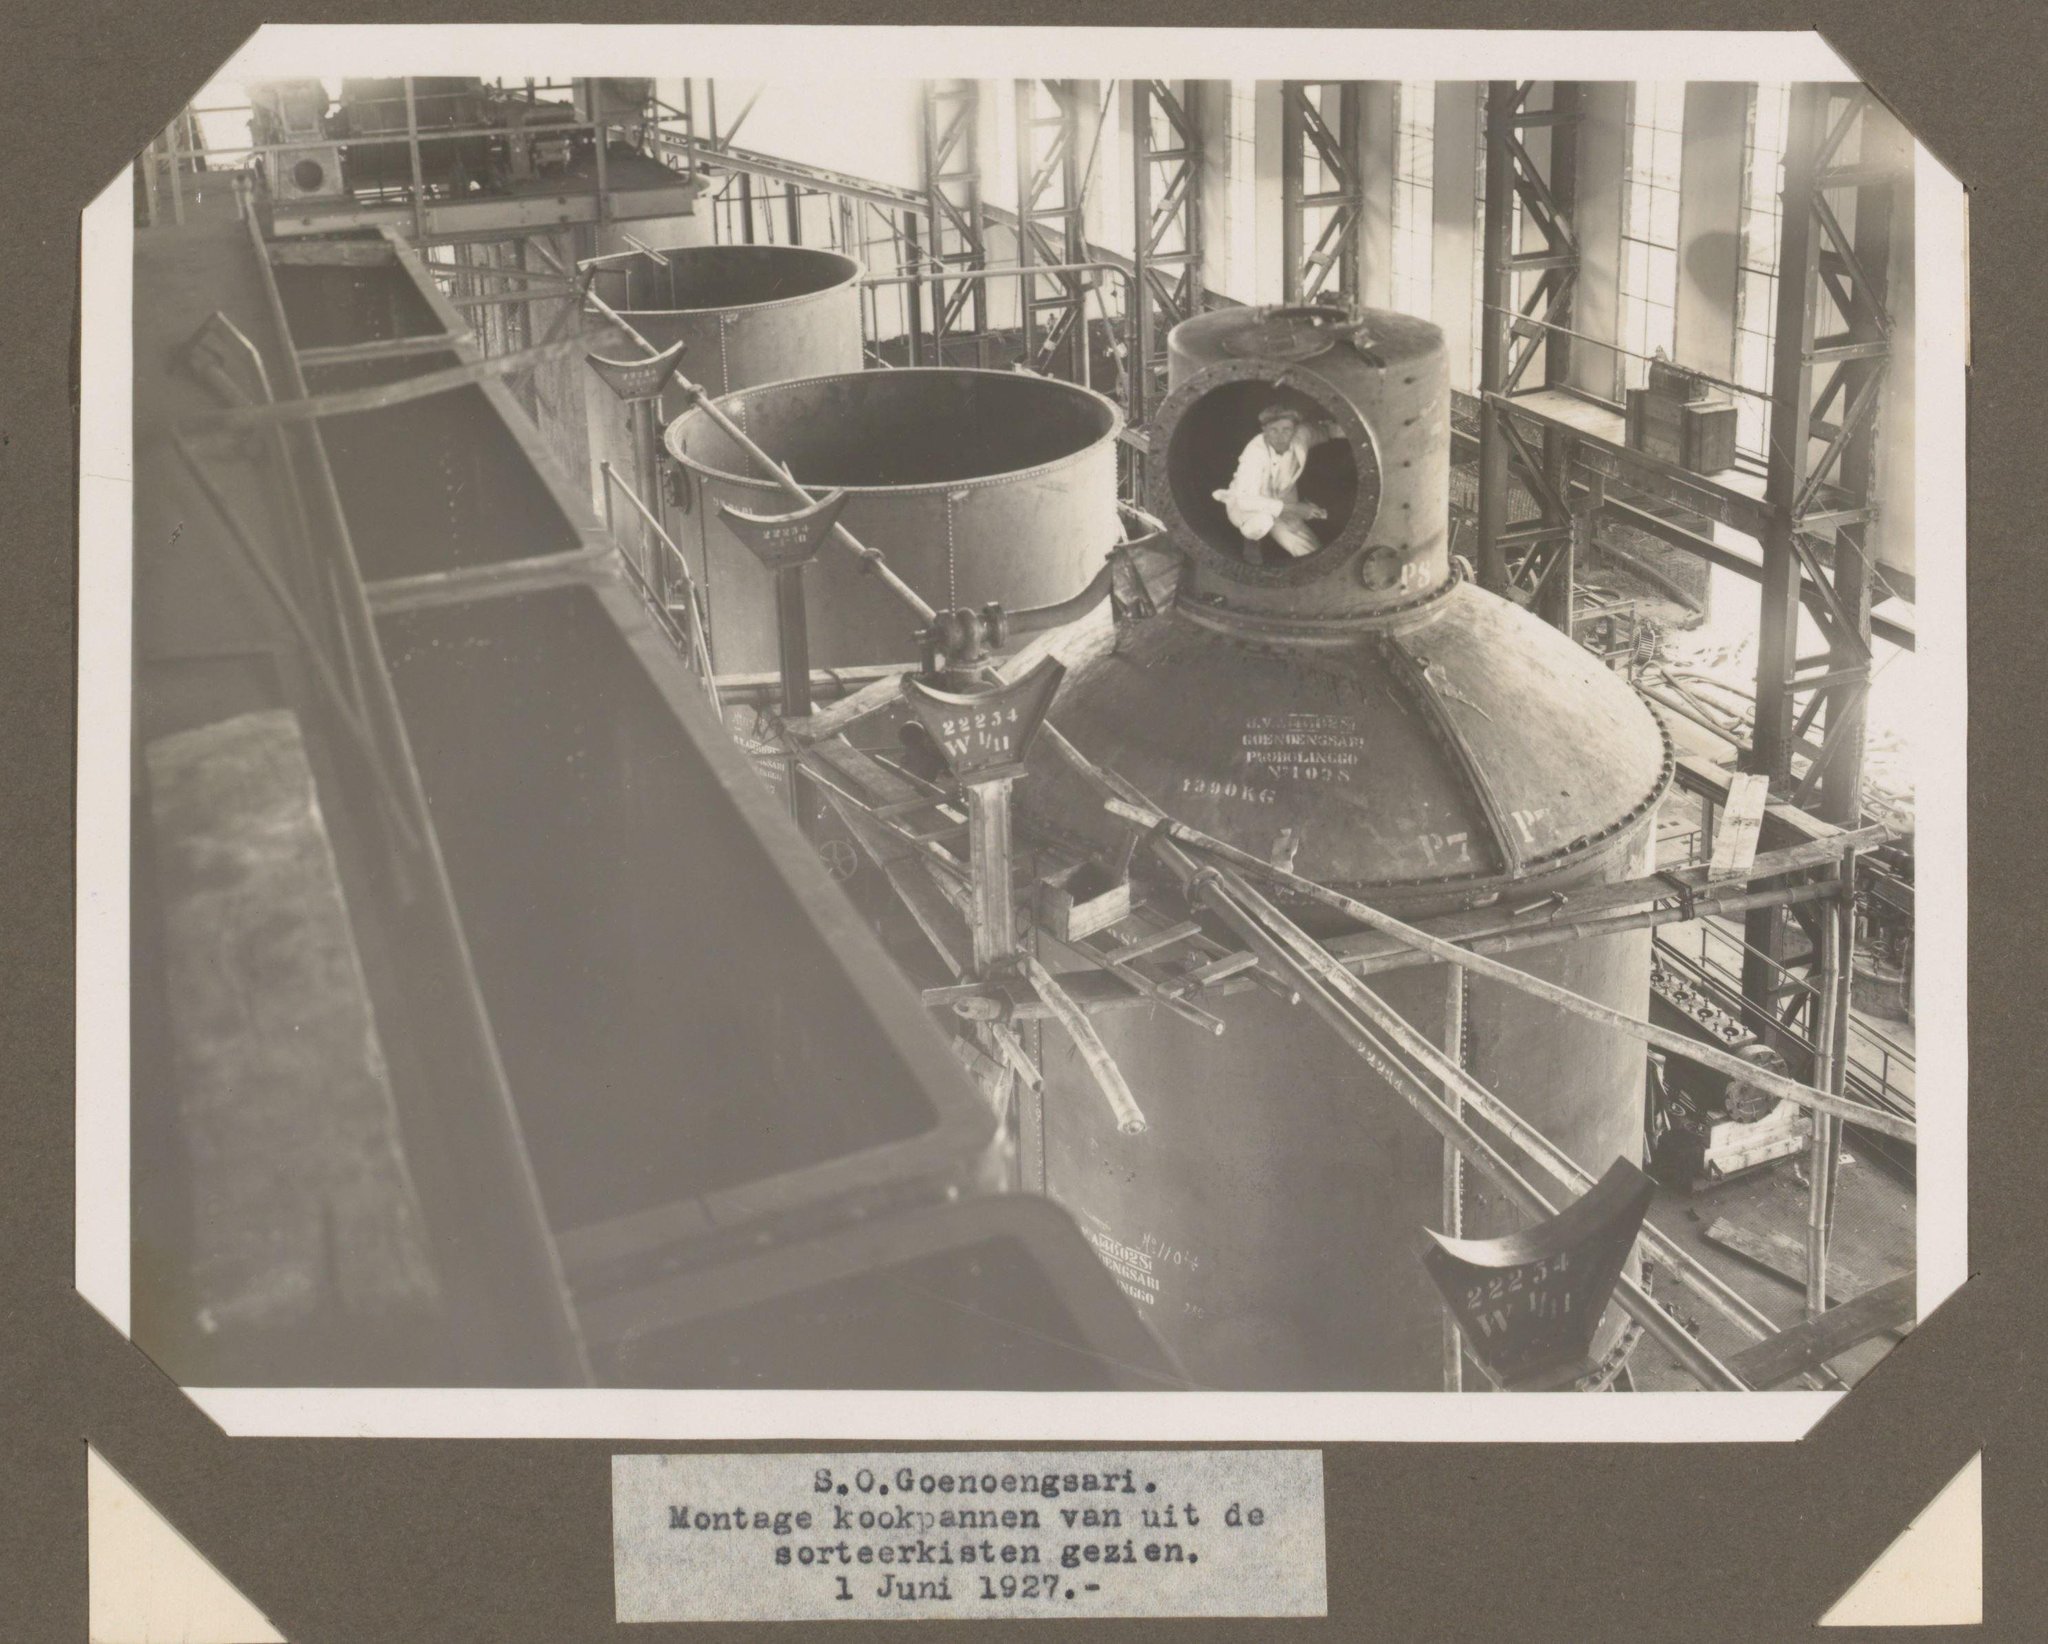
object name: photograph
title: S.O. Goenoengsari. Montage kookpannen van uit de sorteerkisten gezien. 1 Juni 1927.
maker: Anonymous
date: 1906-1927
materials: photographic support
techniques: gelatin silver print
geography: east java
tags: colonial system, trade-company, factory-interior, machine shop, making the overground structures (~ building activities), (non-fruit) products of plants or trees: sugarcane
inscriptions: inscription: ‘S.O. Goenoengsari. Montage kookpannen van uit de sorteerkisten gezien. 1 Juni 1927.’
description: Montage van ketels in de fabriek, juni 1927. Onderdeel van het fotoalbum met foto's van de opbouw van de suikerfabriek te Goenoengsari op Oost-Java door de Handels Vereniging Amsterdam 1926-1927.